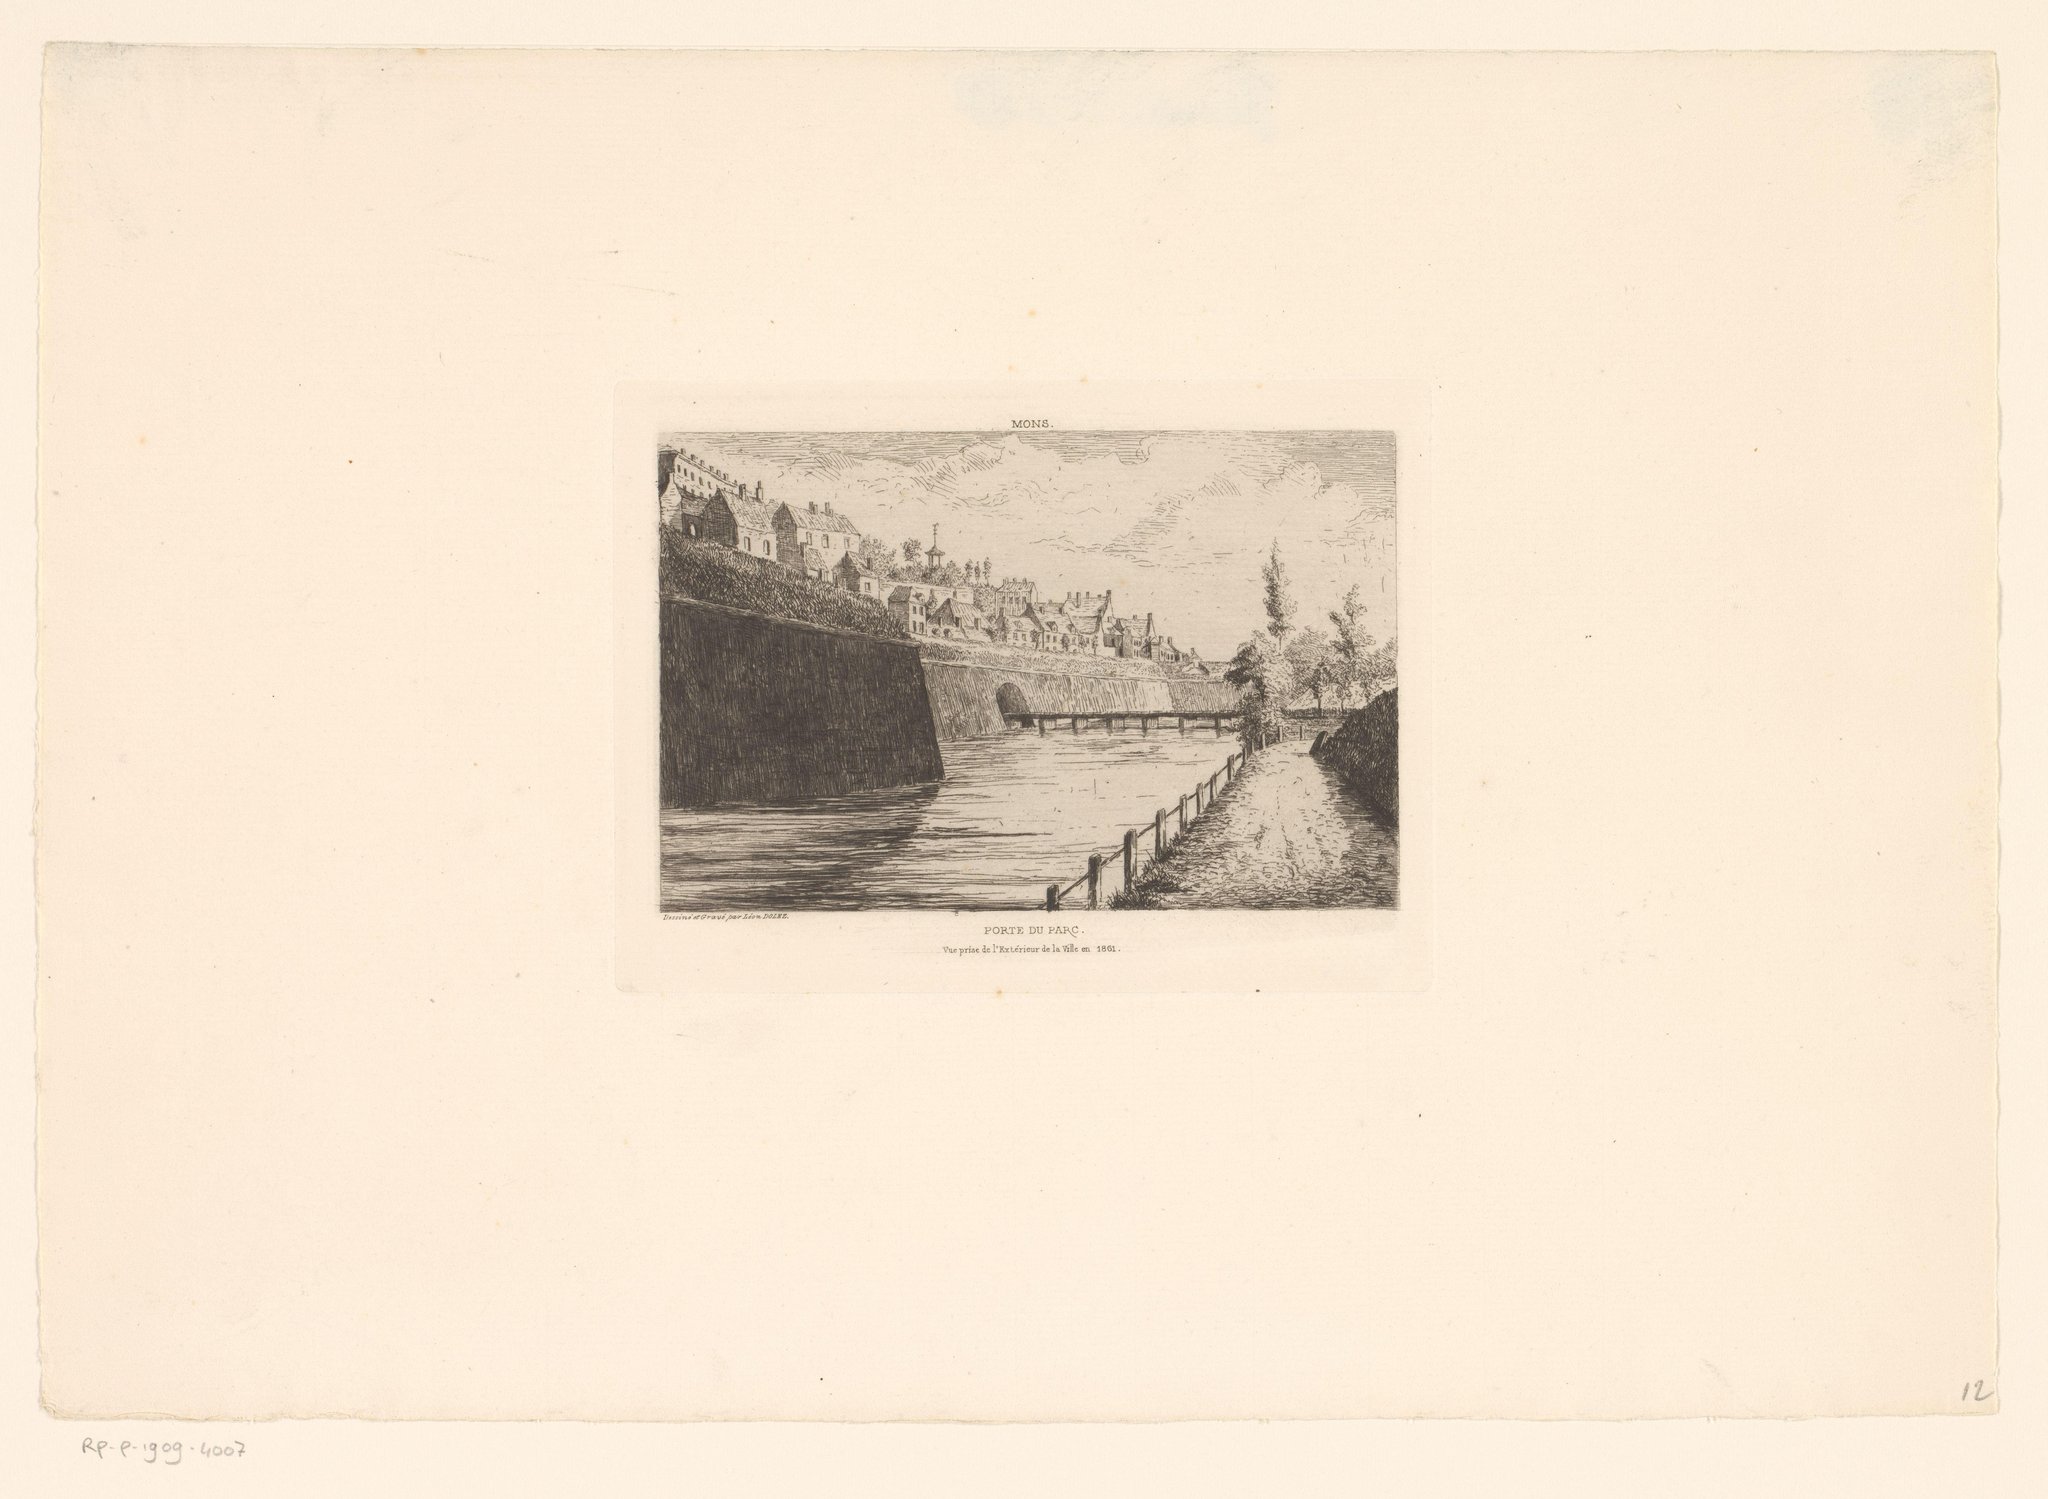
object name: print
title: Vestingwerken van Mons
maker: léon dolez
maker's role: print maker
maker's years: 1837-1902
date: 1875-1878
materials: paper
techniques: drypoint, etching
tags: city-view, and landscape with man-made constructions, city-gate, public gardens, park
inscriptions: collector's mark: Lugt 2228